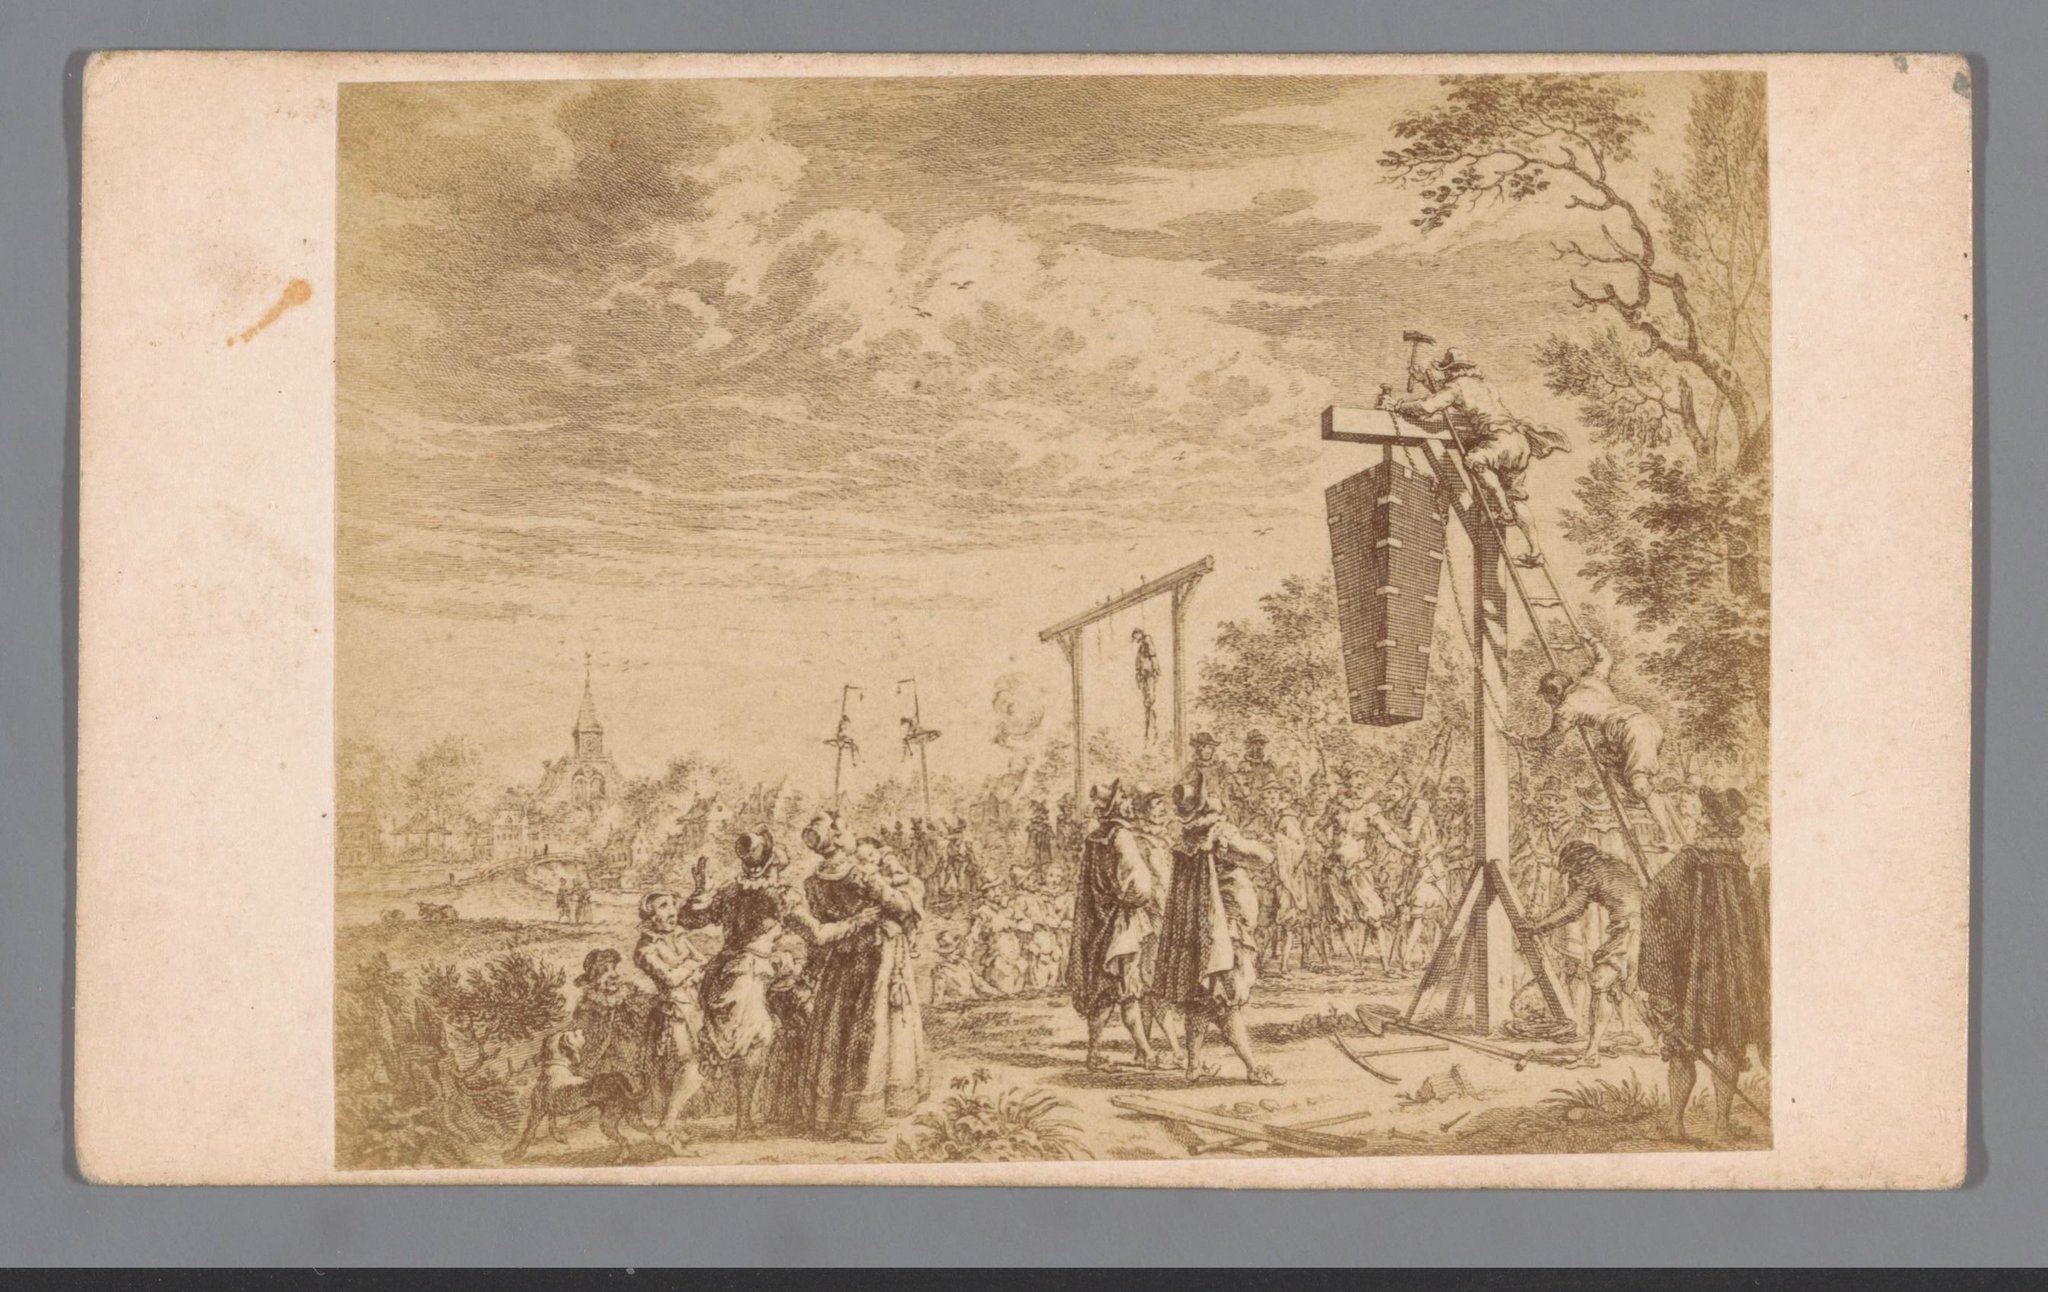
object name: photograph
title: Fotoreproductie van een gravure van het lijk van Gilles van Ledenberg in een kist aan een galg opgehangen in 1619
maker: Anonymous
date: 1850-1900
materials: cardboard, photographic support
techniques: albumen print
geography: netherlands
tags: utrecht, death penalty, execution, the hague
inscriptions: inscription: ‘Het lijk (...) verbeurd verklaard.’, number: ‘46’, number: ‘46’